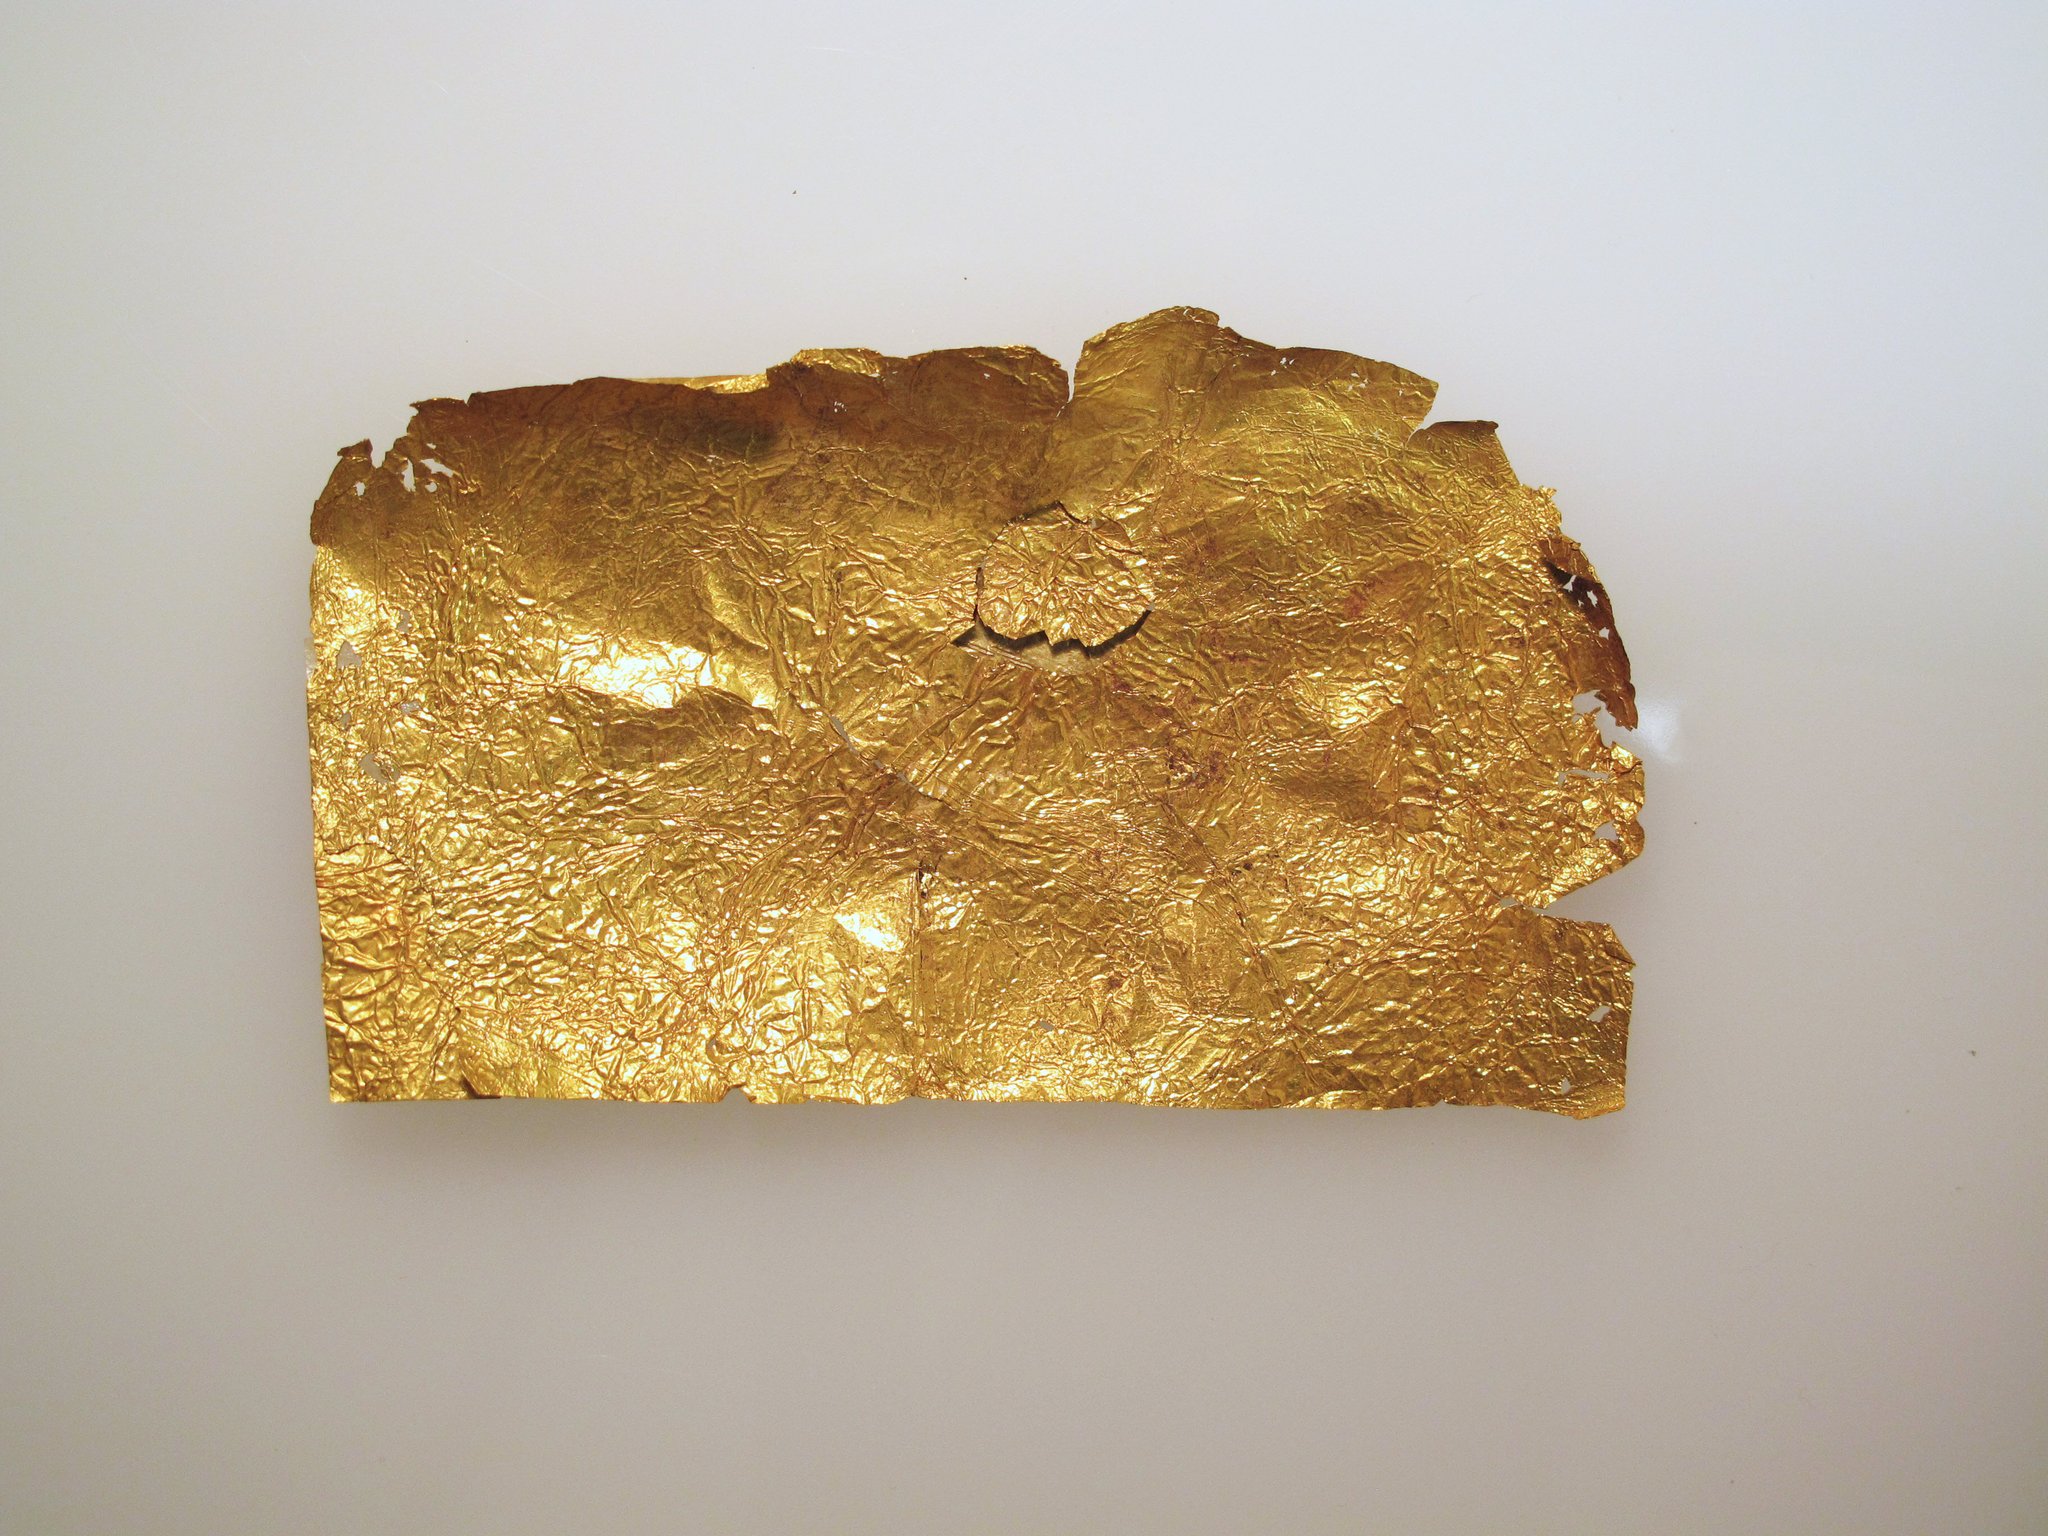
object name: frontlet of gold leaf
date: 7000 BCE-330 CE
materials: gold